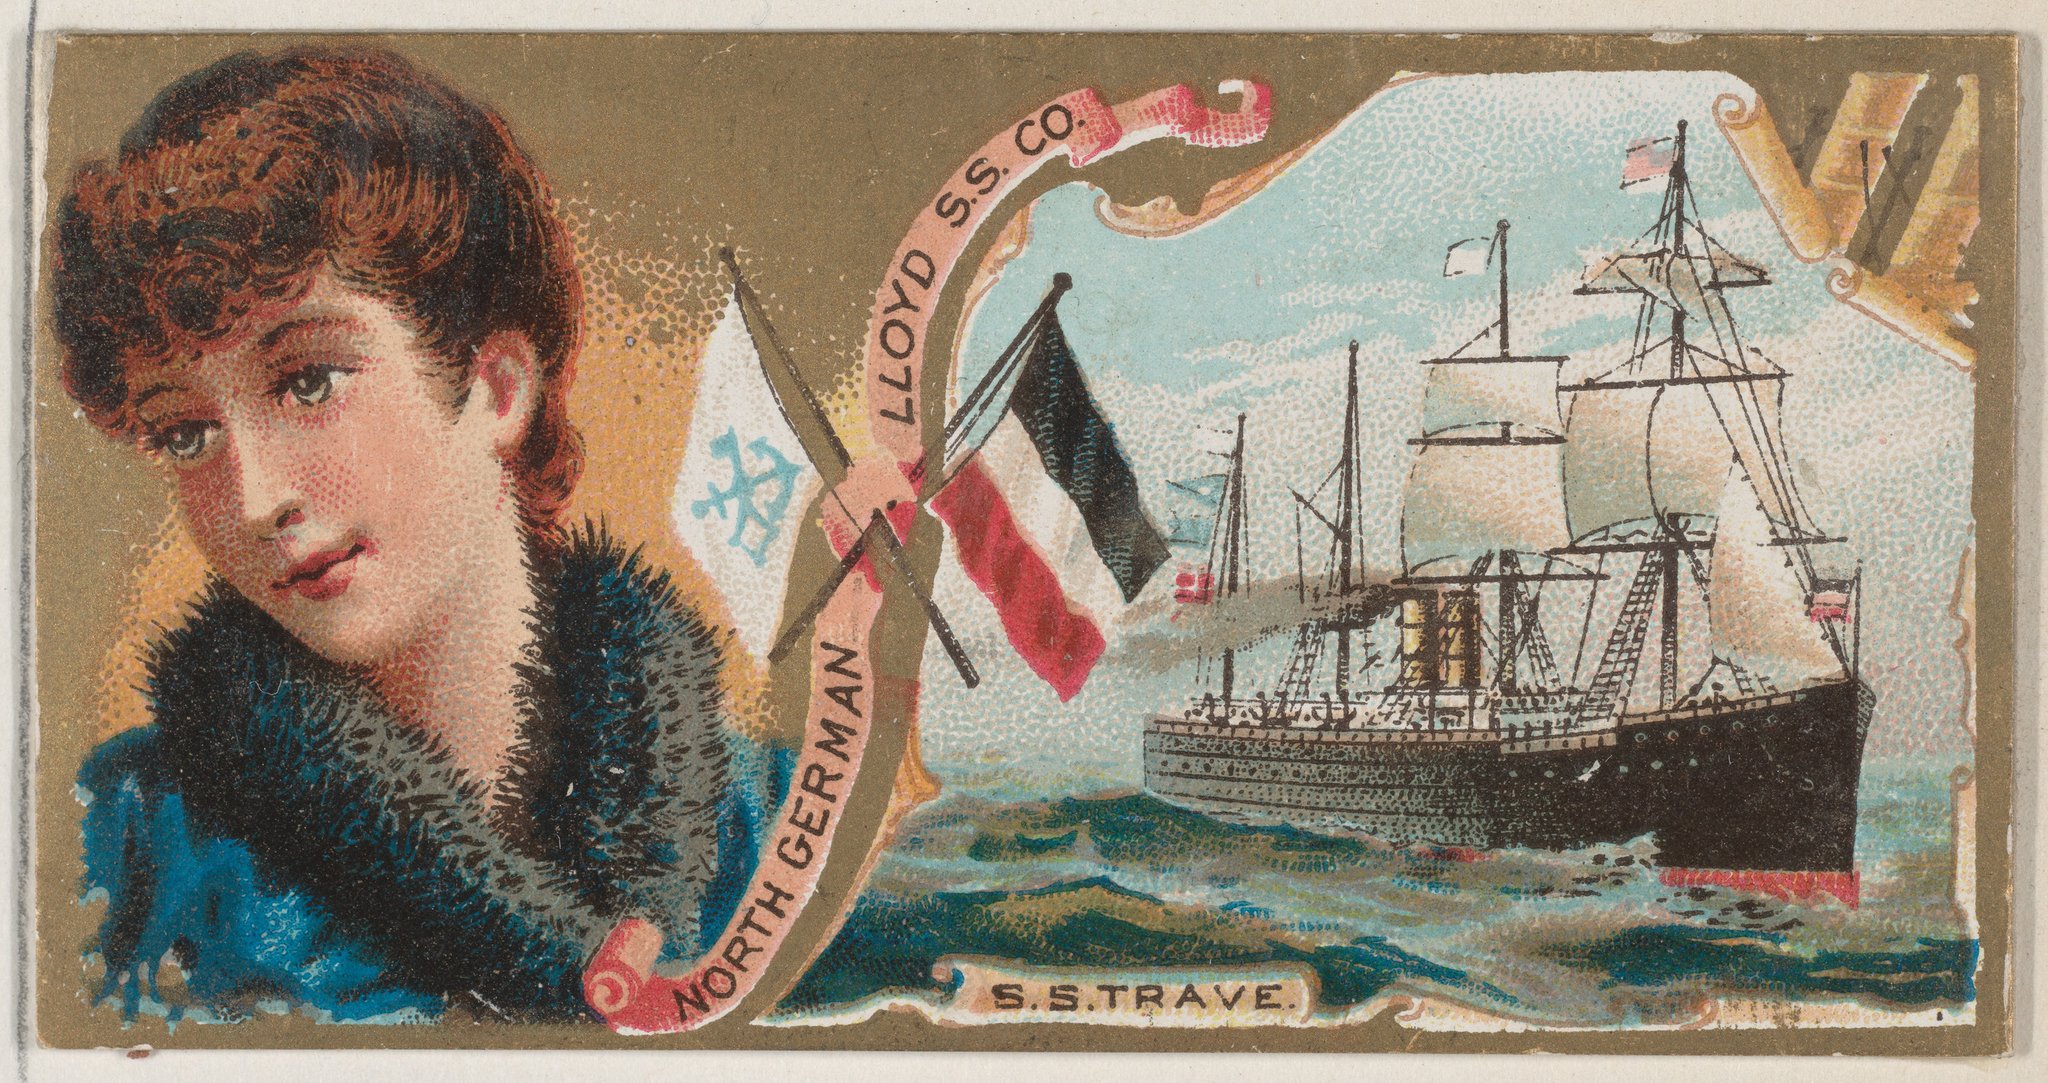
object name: print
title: Steamship Trave, North German Lloyd Steamship Company, from the Ocean and River Steamers series (N83) for Duke brand cigarettes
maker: w. duke, sons & co.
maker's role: publisher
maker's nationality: american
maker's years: 1870-1920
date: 1887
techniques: color lithograph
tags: women,ships